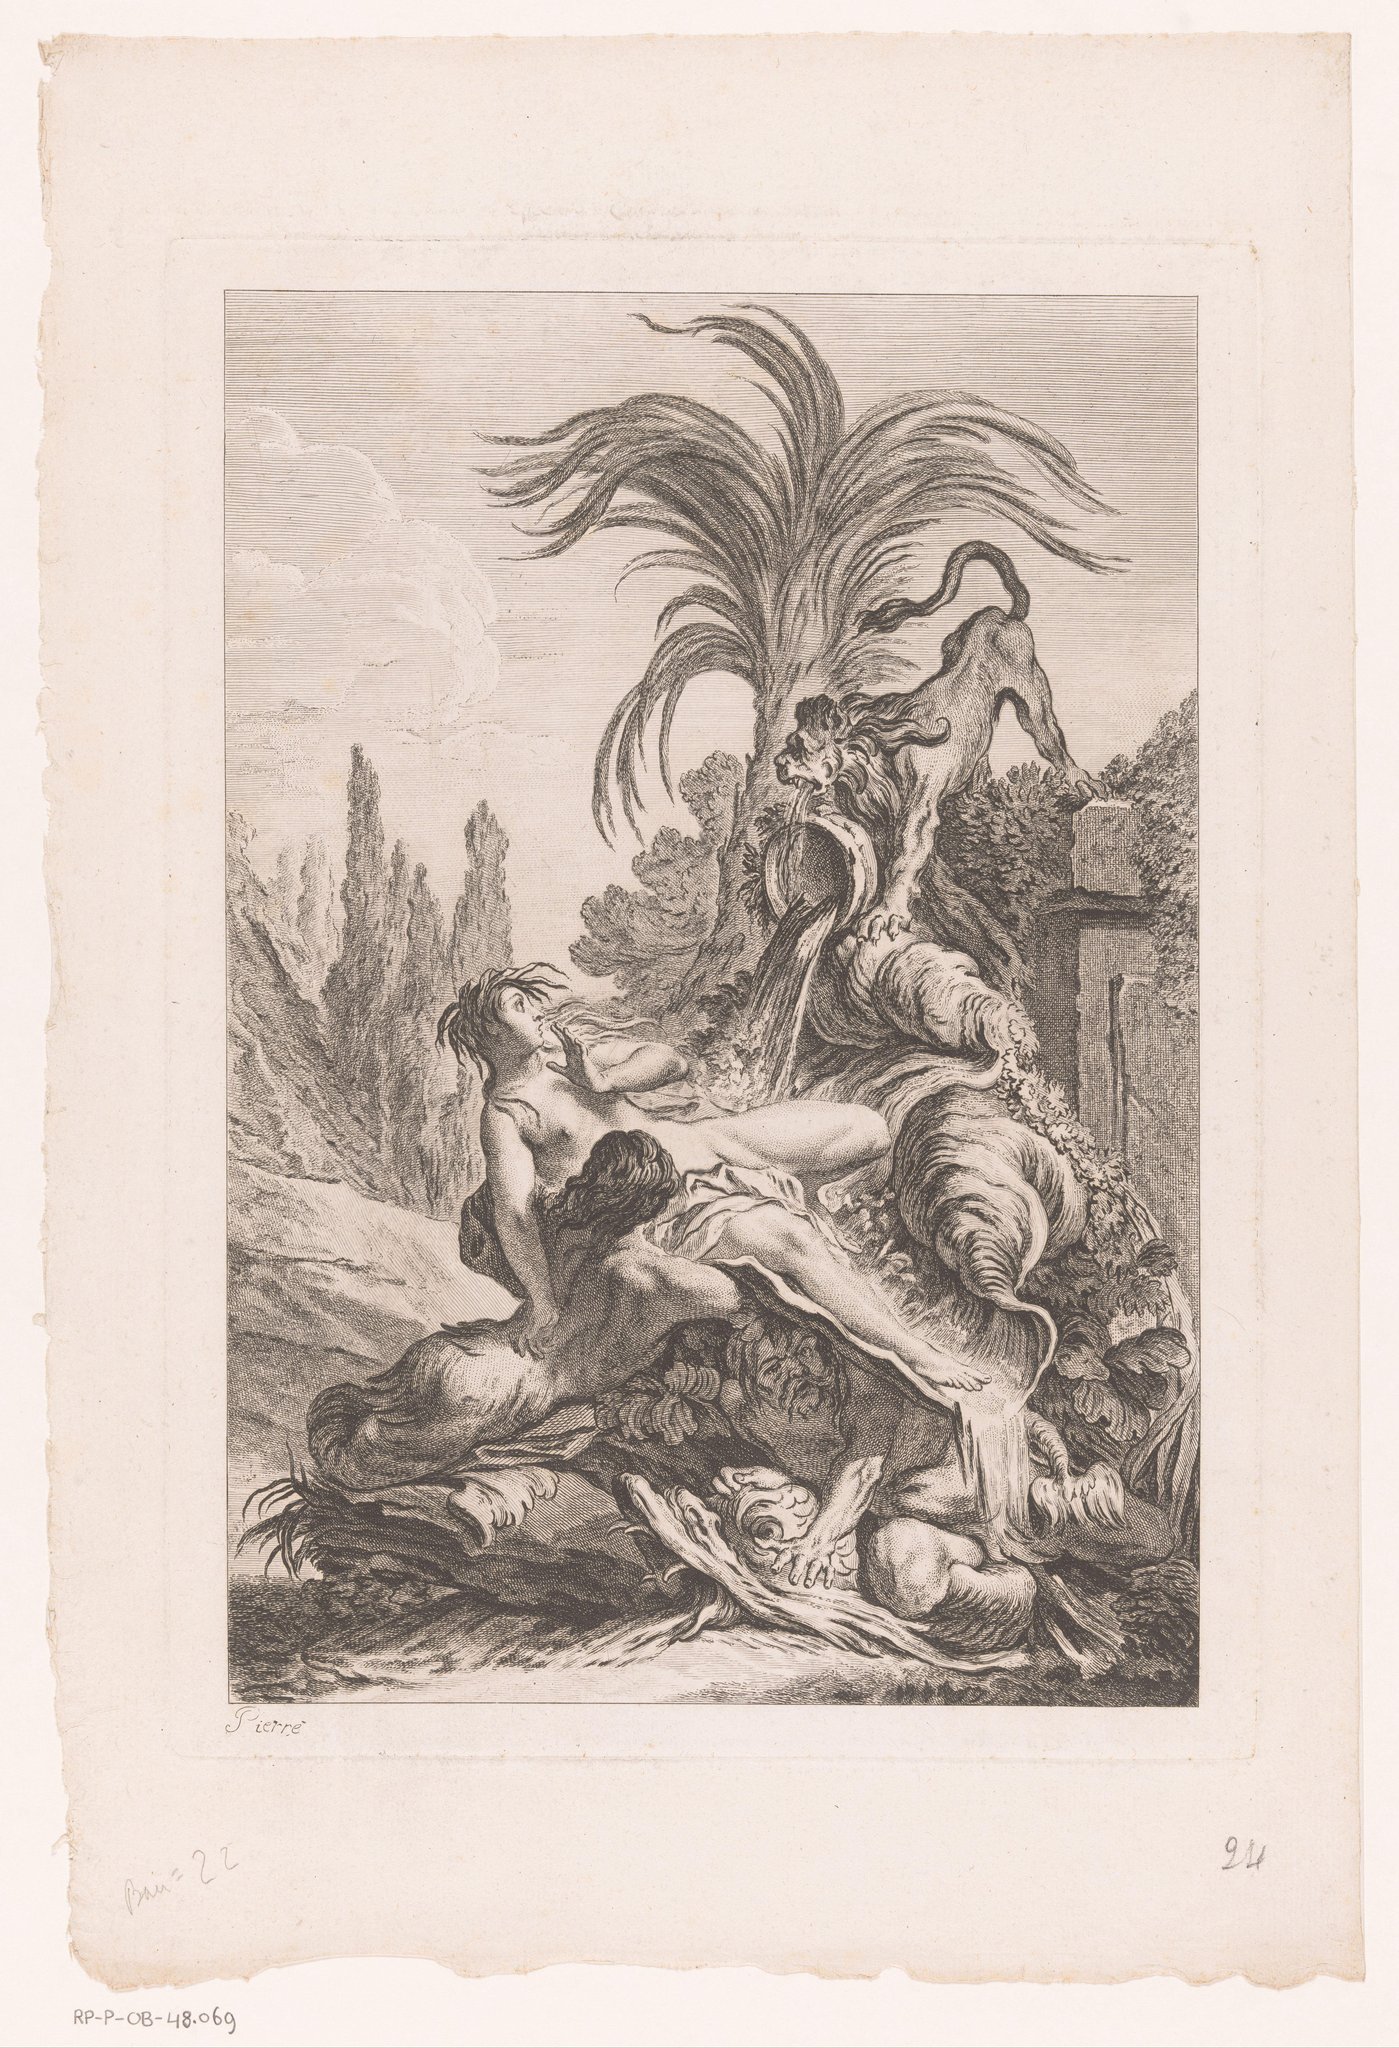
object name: print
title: Fontein met naiade opgeschrikt door leeuw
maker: jean baptiste marie pierre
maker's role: print maker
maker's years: 1713-1789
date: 1740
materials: paper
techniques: etching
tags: garden fountain, naiads, river- and spring-nymphs; usually carrying an urn; 'naiadi, ninfe de' fiumi' (ripa), beasts of prey, predatory animals: lion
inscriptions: collector's mark: Lugt 2228